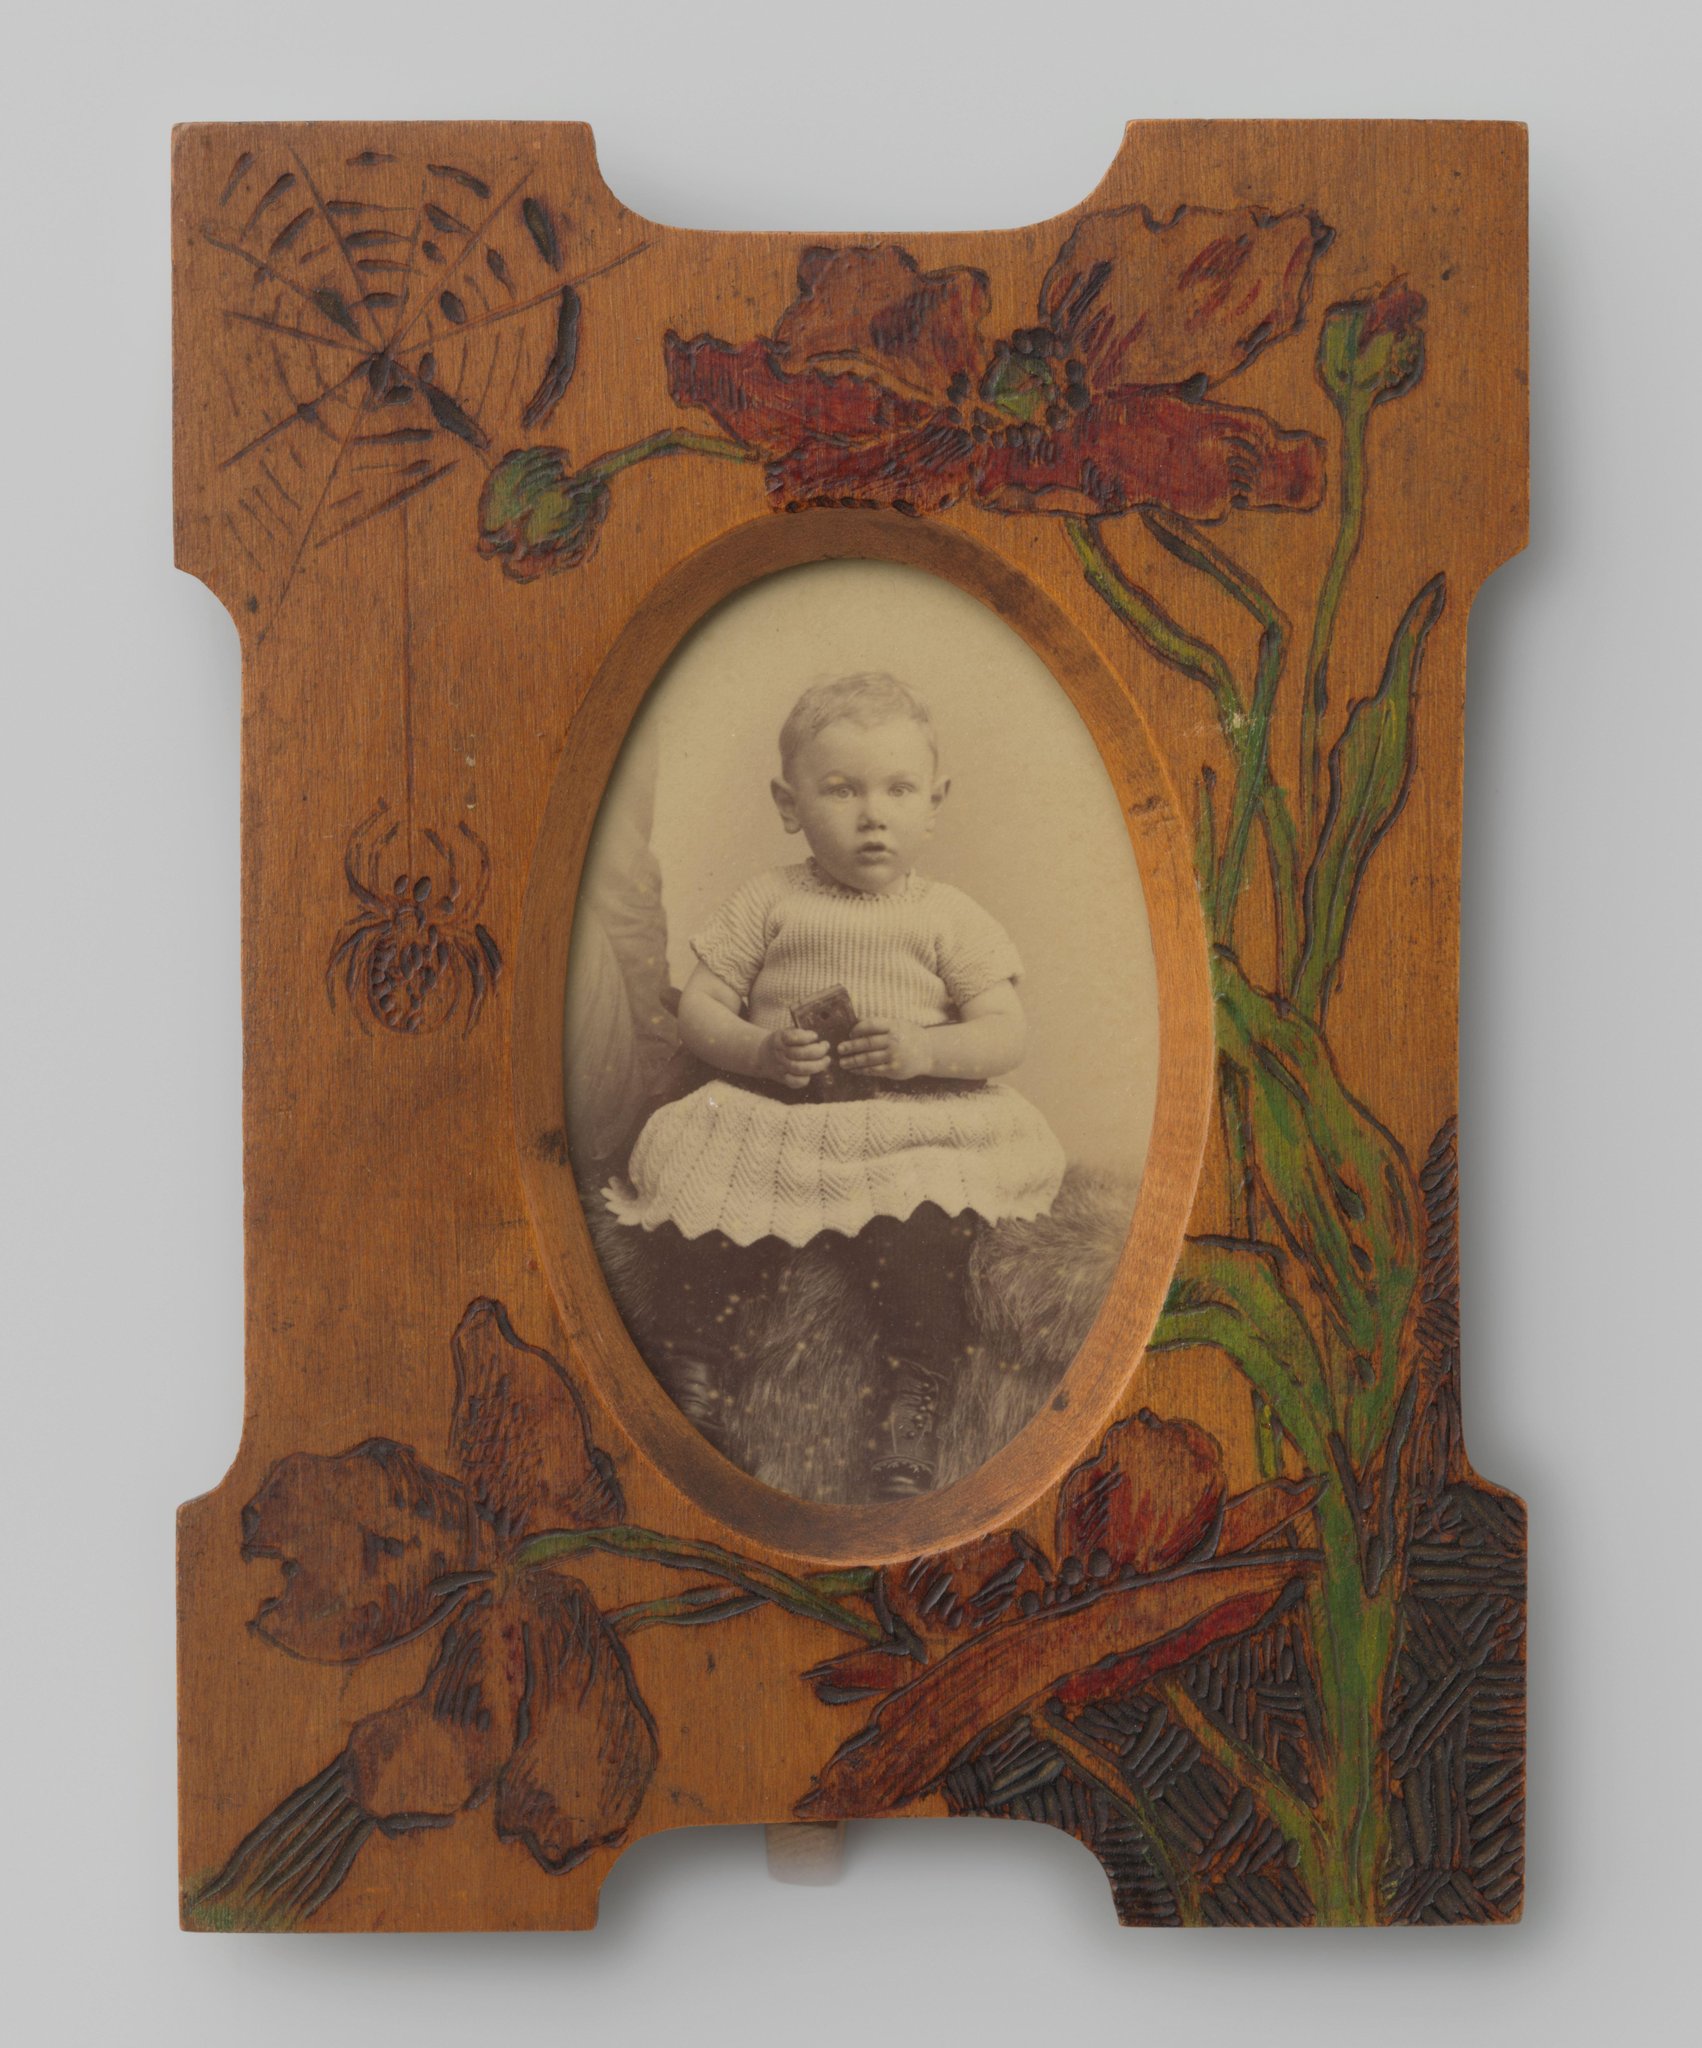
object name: carte de visite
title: Portret van een onbekend kind met een boek in de handen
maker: franz wilhelm heinrich deutmann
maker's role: fotograaf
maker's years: 1840-1906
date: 1880-1906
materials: cardboard, glass, metal, paint, paper, wood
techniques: albumen print, brush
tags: toddler, camera ~ photography, anonymous historical person portrayed